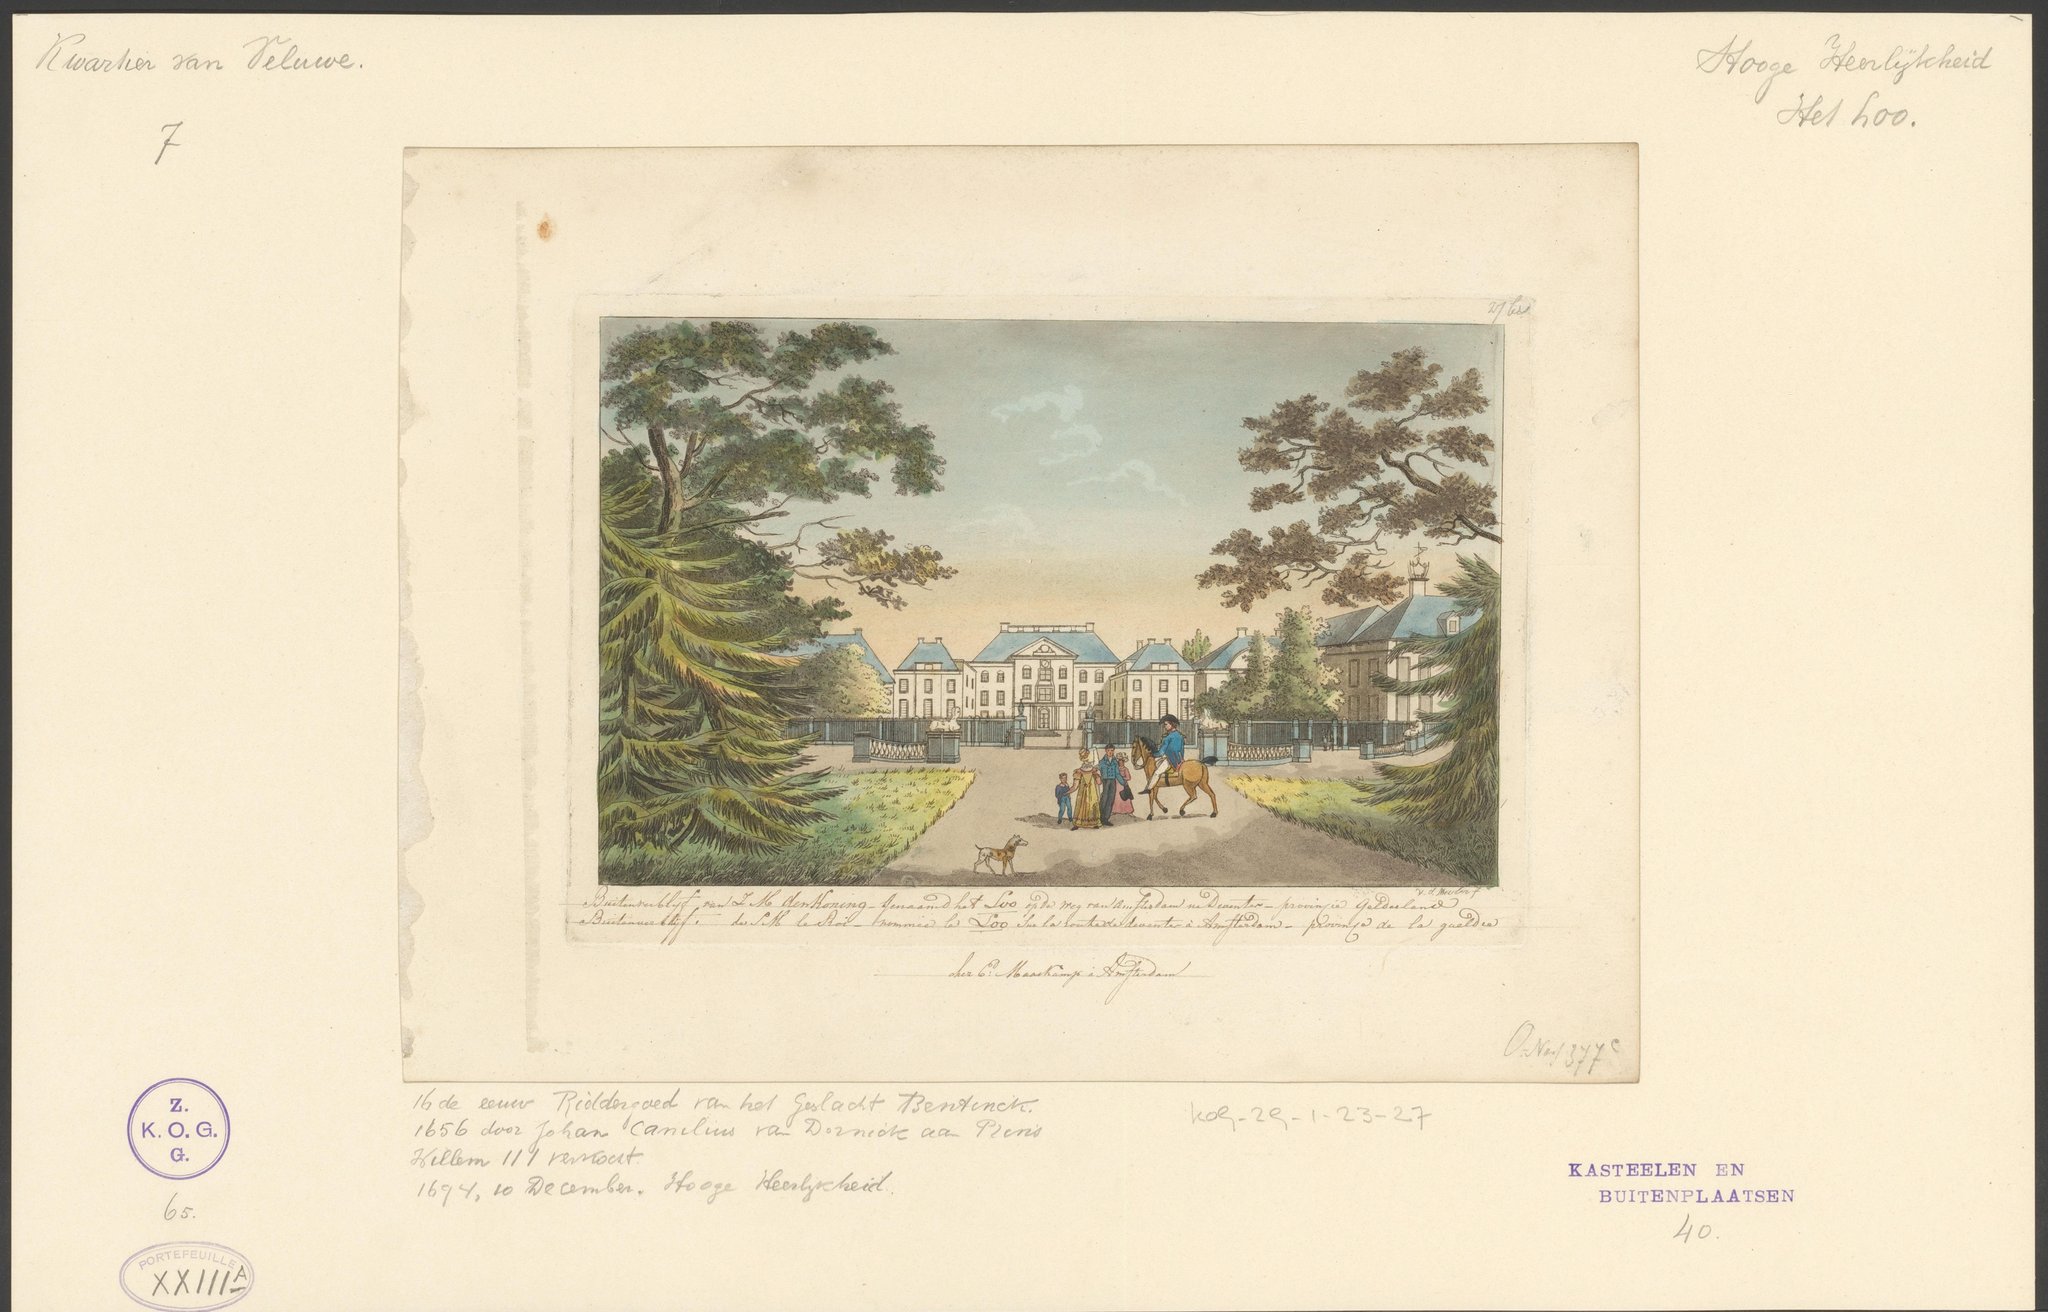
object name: print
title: Paleis Het Loo te Apeldoorn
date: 1816-1833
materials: paper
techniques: aquatint, etching, hand coloring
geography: amsterdam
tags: palace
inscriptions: stamp, collector's mark: Lugt 1641, stamp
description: Prent mogelijk gebruikt in een van de edities van: Maaskamp, Evert. Tableau des principales vues des palais et édifices : représentations et des coutumes et usages, dans les provinces septentrionales du Royaume des Pays-Bas. Amsterdam, Evert Maaskamp, 1824.